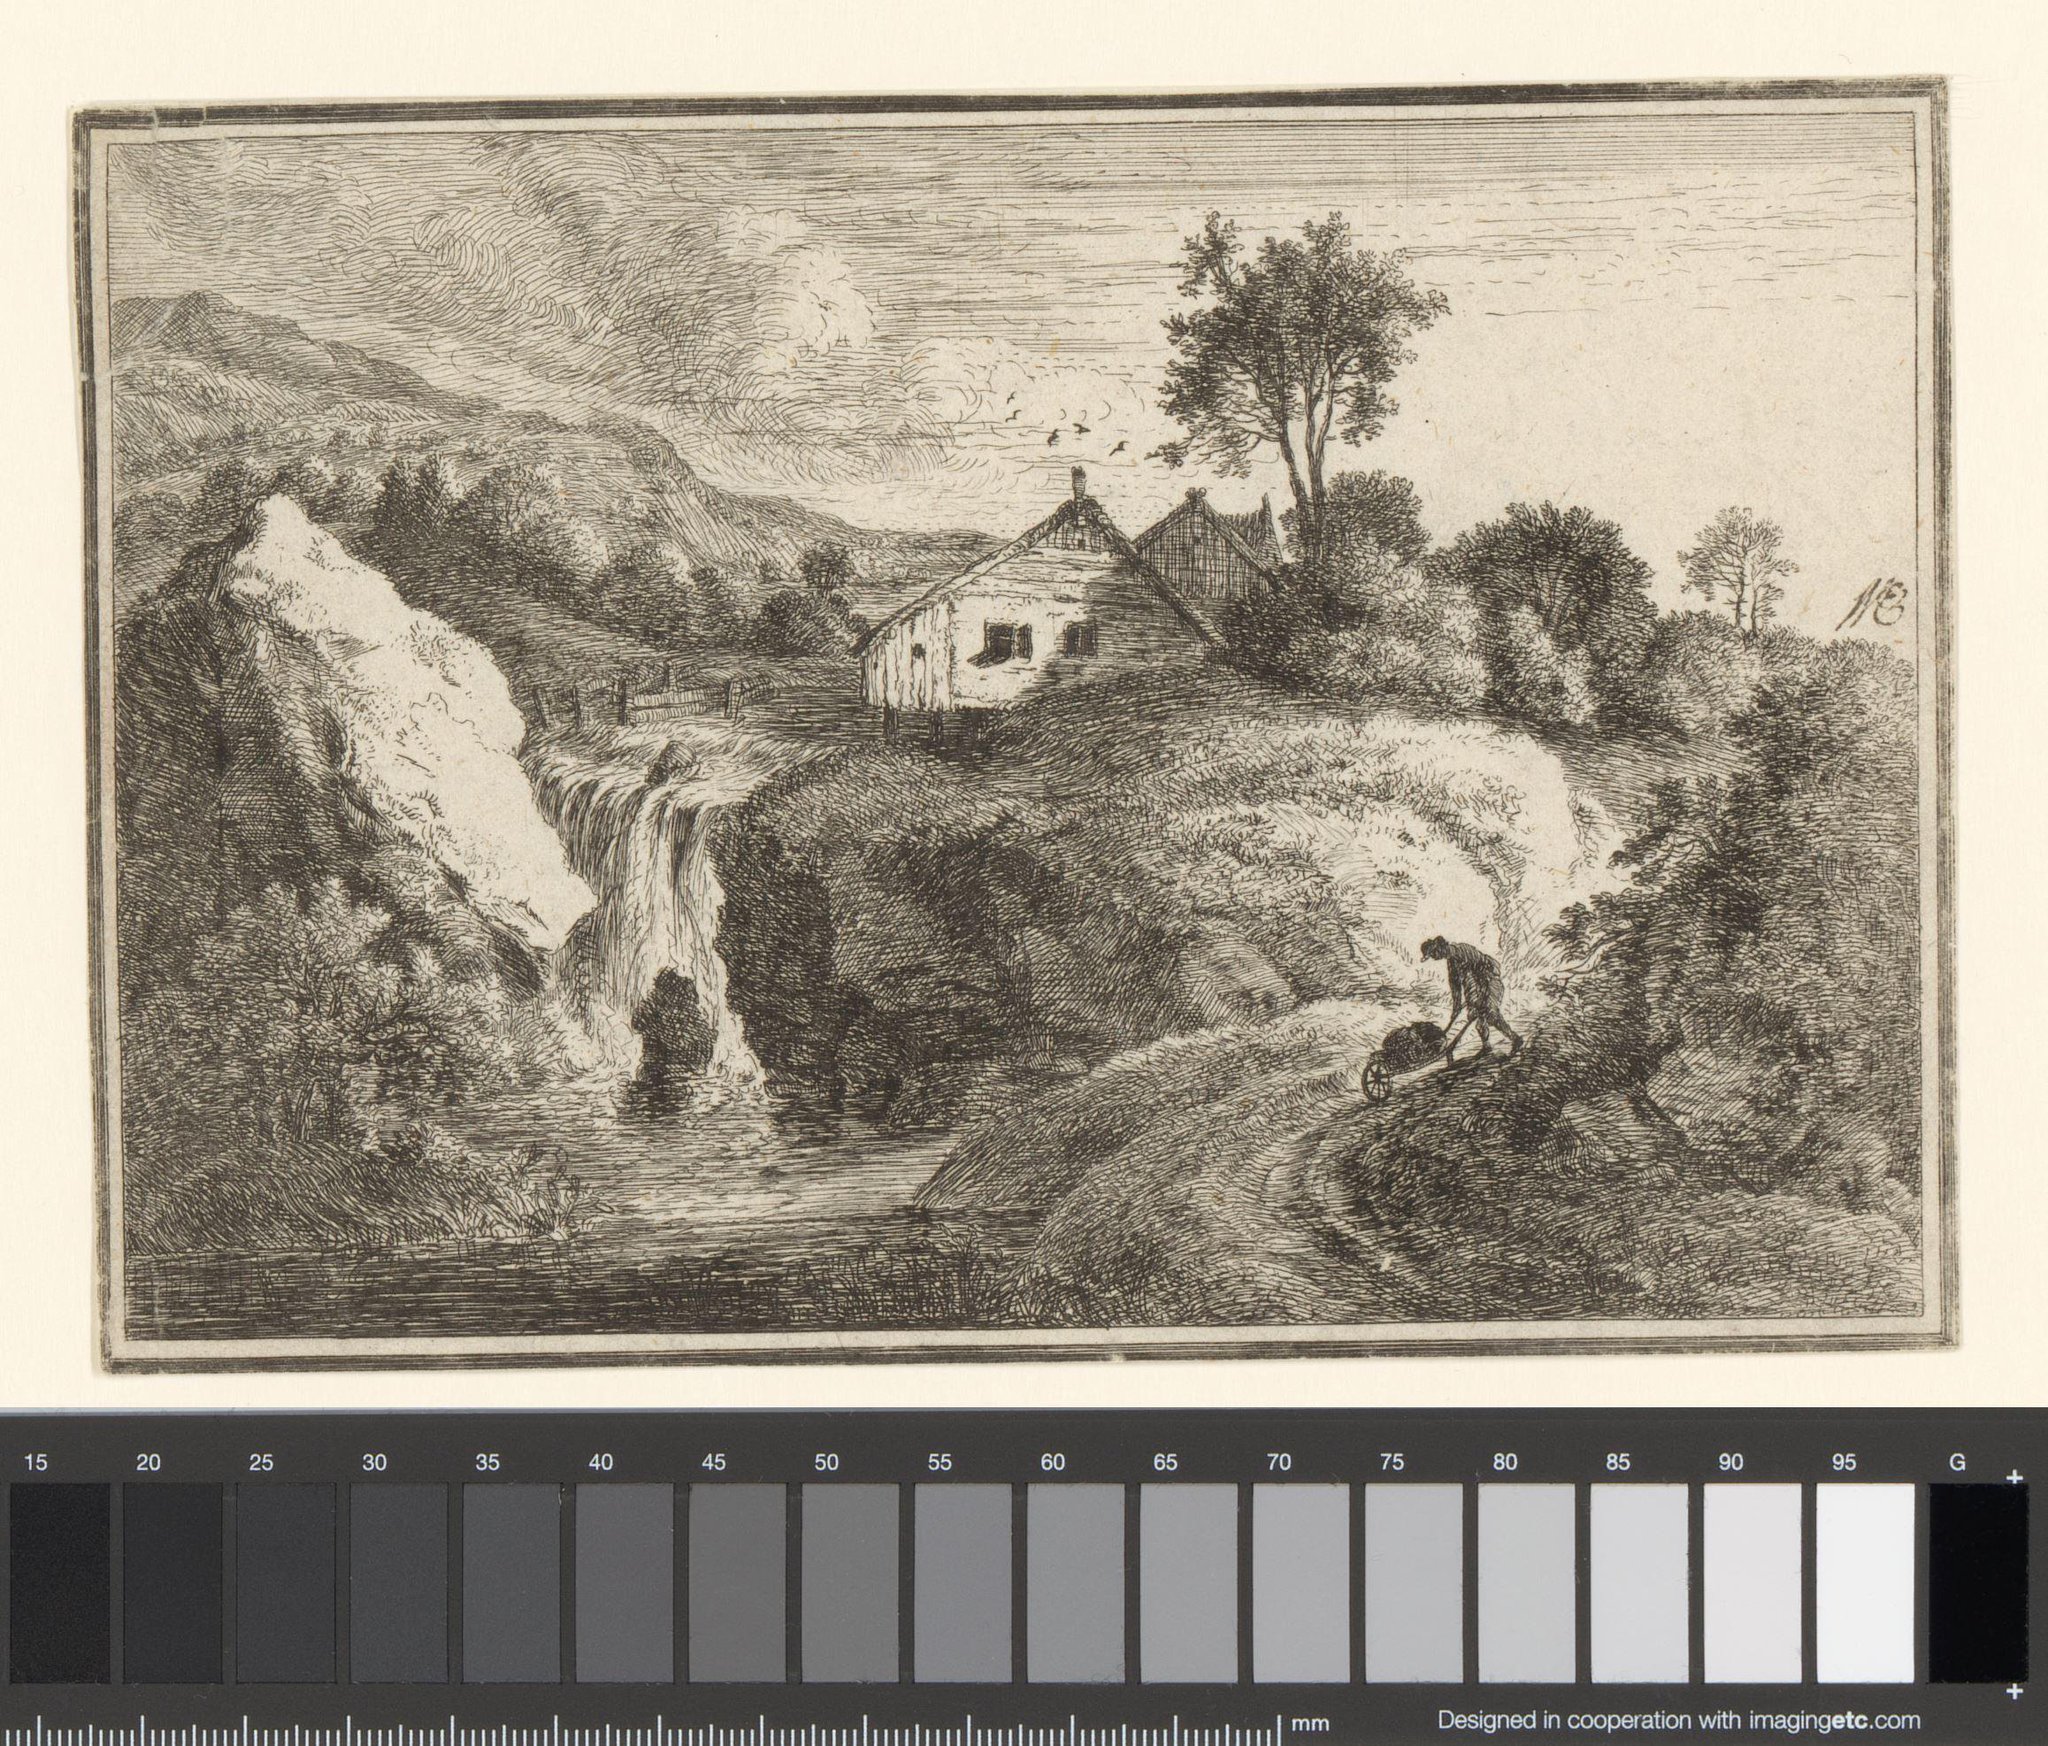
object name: print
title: Landschap met een waterval en een man met een kruiwagen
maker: j. roemer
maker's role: print maker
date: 1600-1699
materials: paper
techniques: etching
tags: landscapes, waterfall, wheelbarrow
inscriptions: collector's mark: Lugt 2228